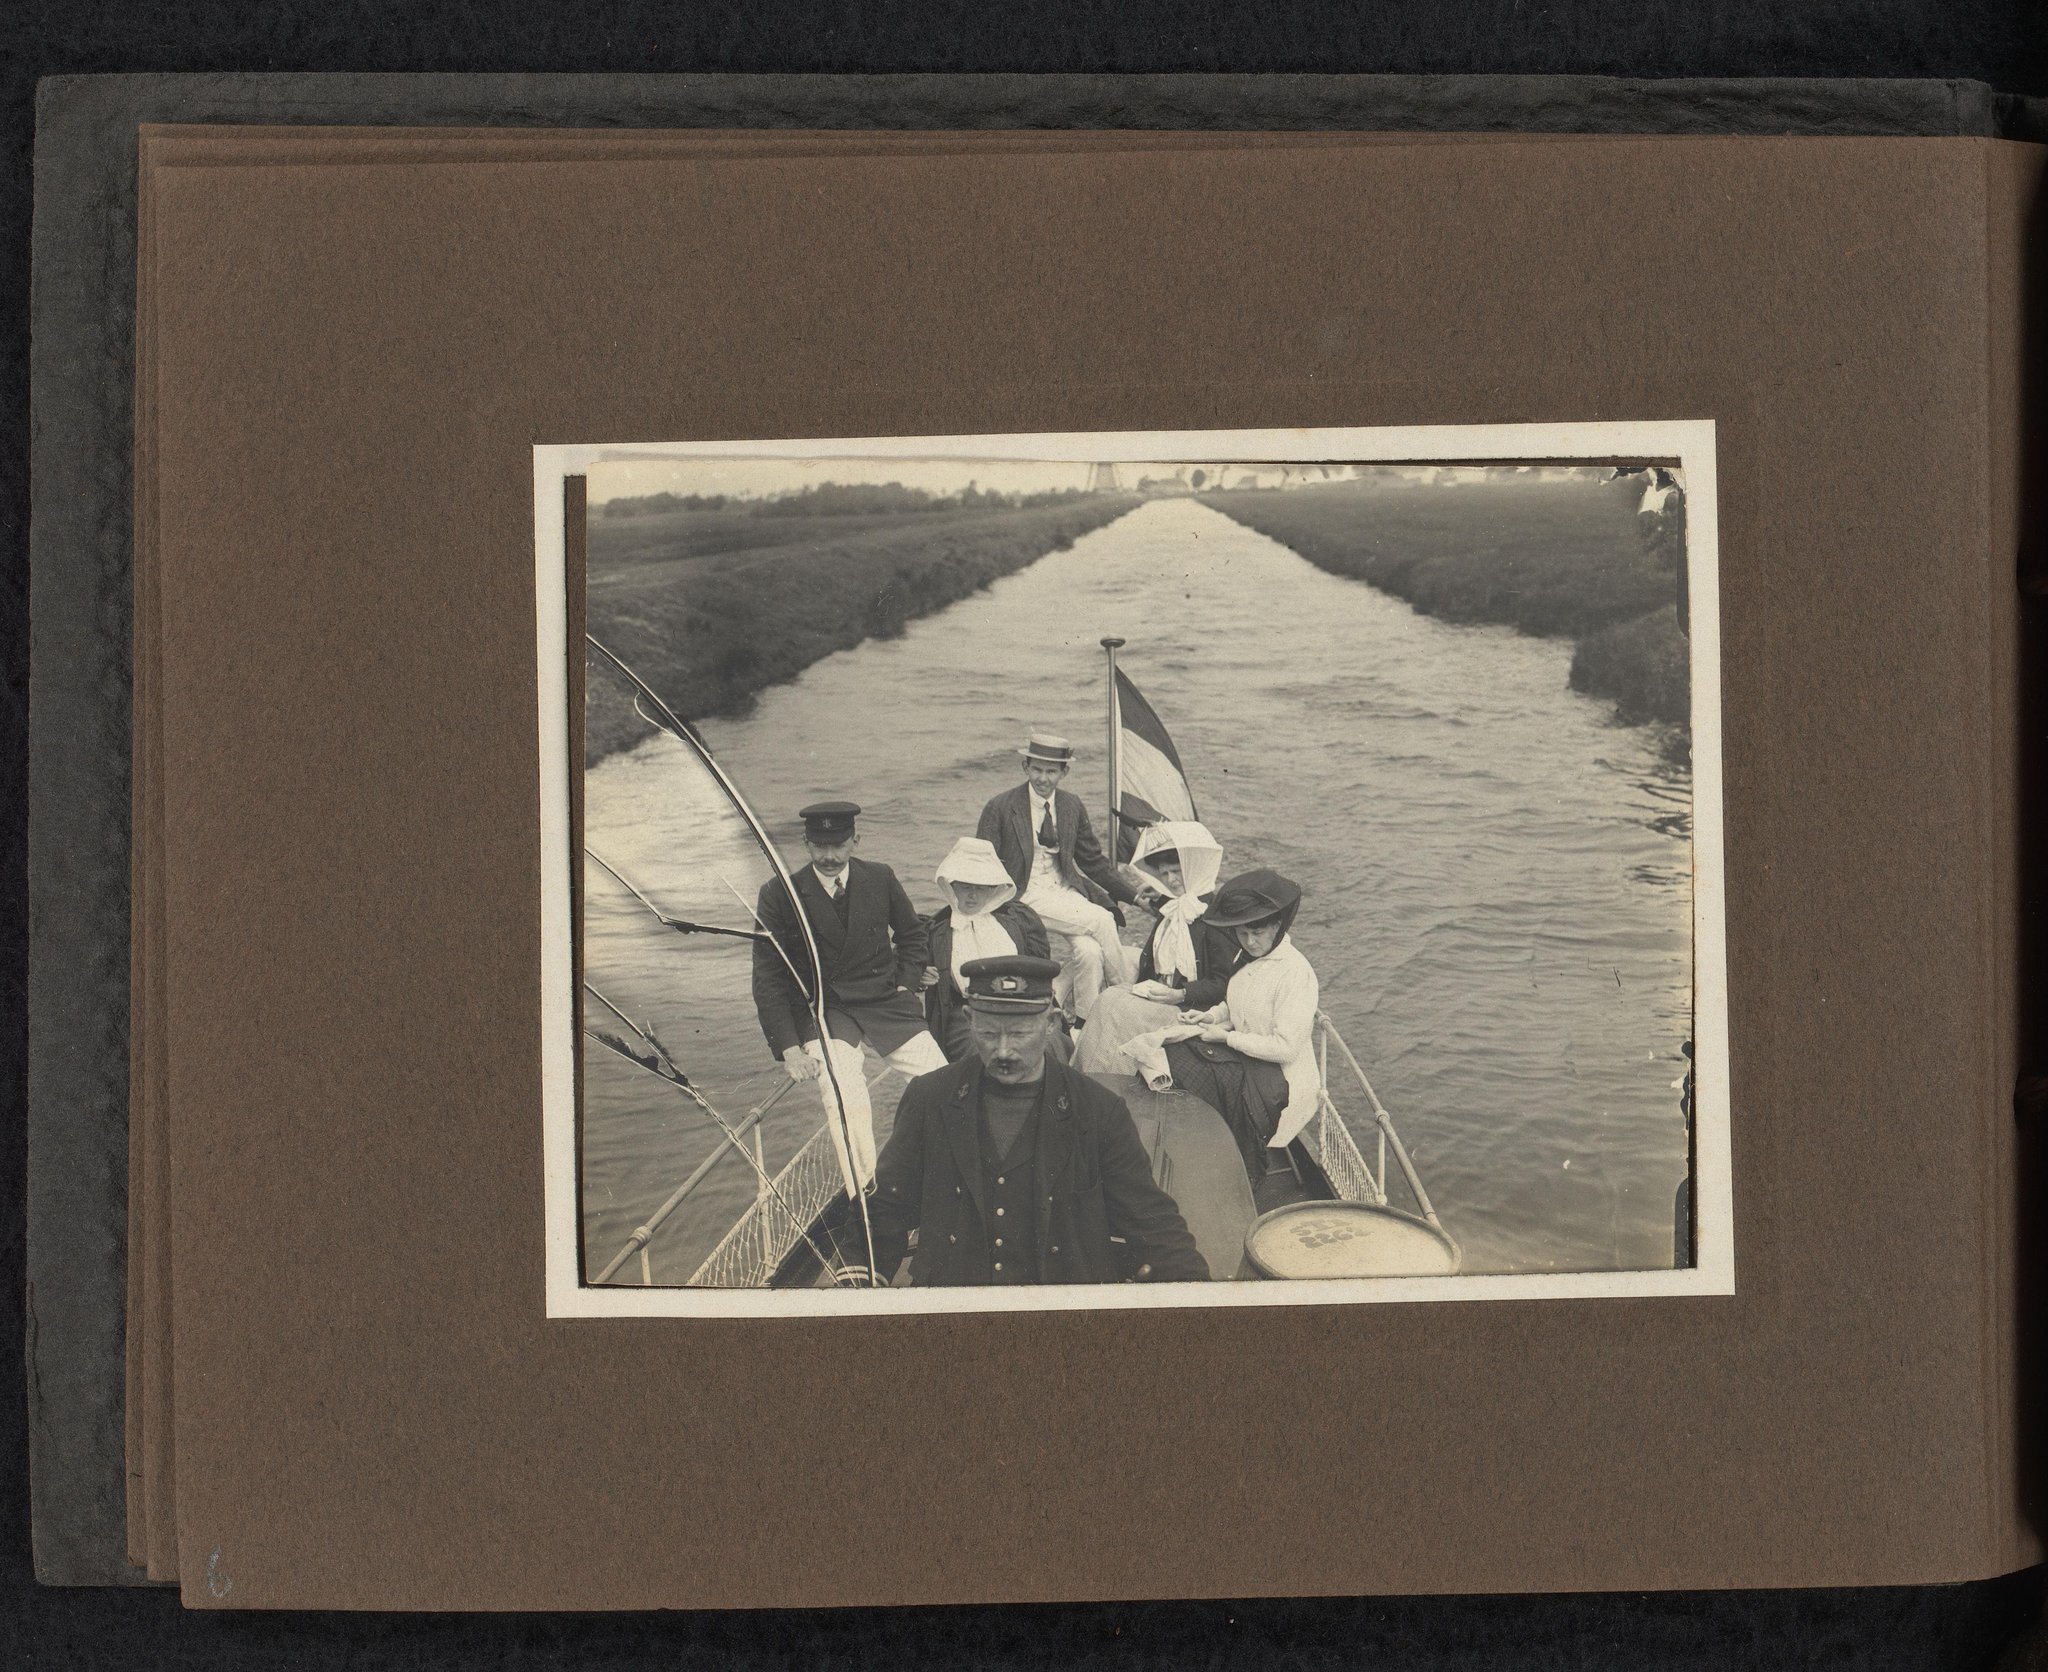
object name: photograph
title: Gezelschap op een motorboot in een vaart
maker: hendrik herman van den berg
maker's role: amateurfotograaf, jurist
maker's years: 1875-1944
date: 1908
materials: paper, cardboard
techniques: gelatin silver print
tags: historical persons, canal, steamship, motorship